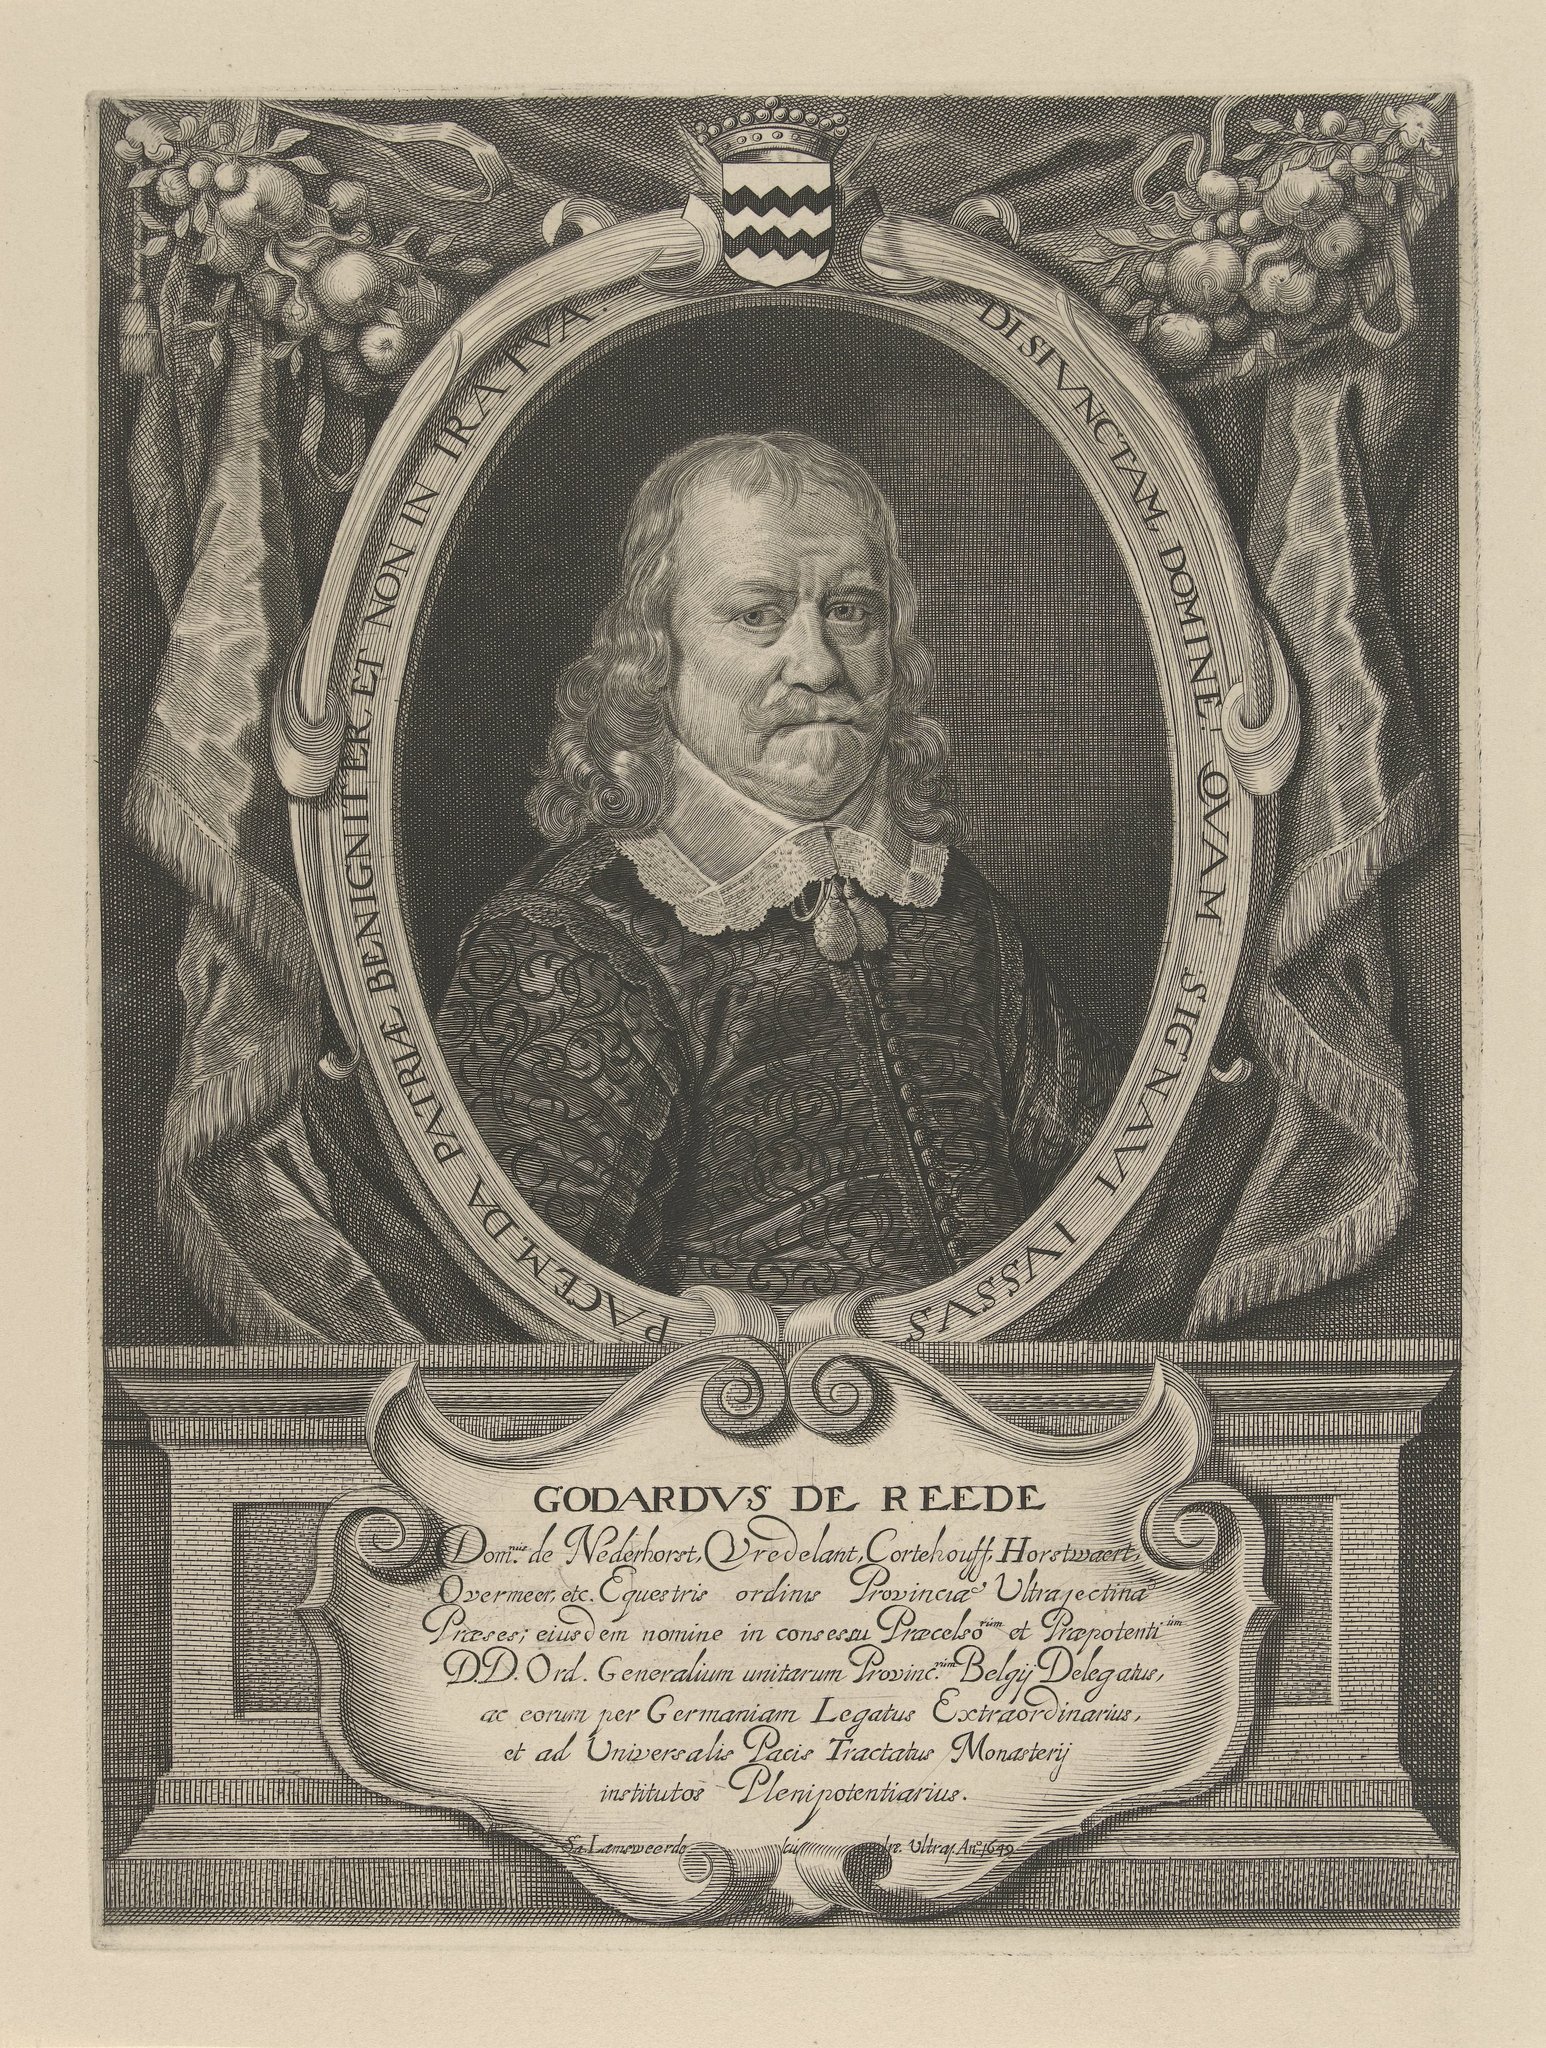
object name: print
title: Godardus de Reede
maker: steven van lamsweerde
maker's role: print maker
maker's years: 1620-1686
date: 1649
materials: paper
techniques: engraving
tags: utrecht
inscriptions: date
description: Portretbuste in ovaal naar rechts van Godard van Reede, heer van Nederhorst, blootshoofds. De ovale omlijsting bevat een randschrift in Latijn en is getooid met een wapen. Het ovaal steunt op een sokkel met cartouche waarop de naam van de geportretteerde en een zevenregelig Latijns vers staat.